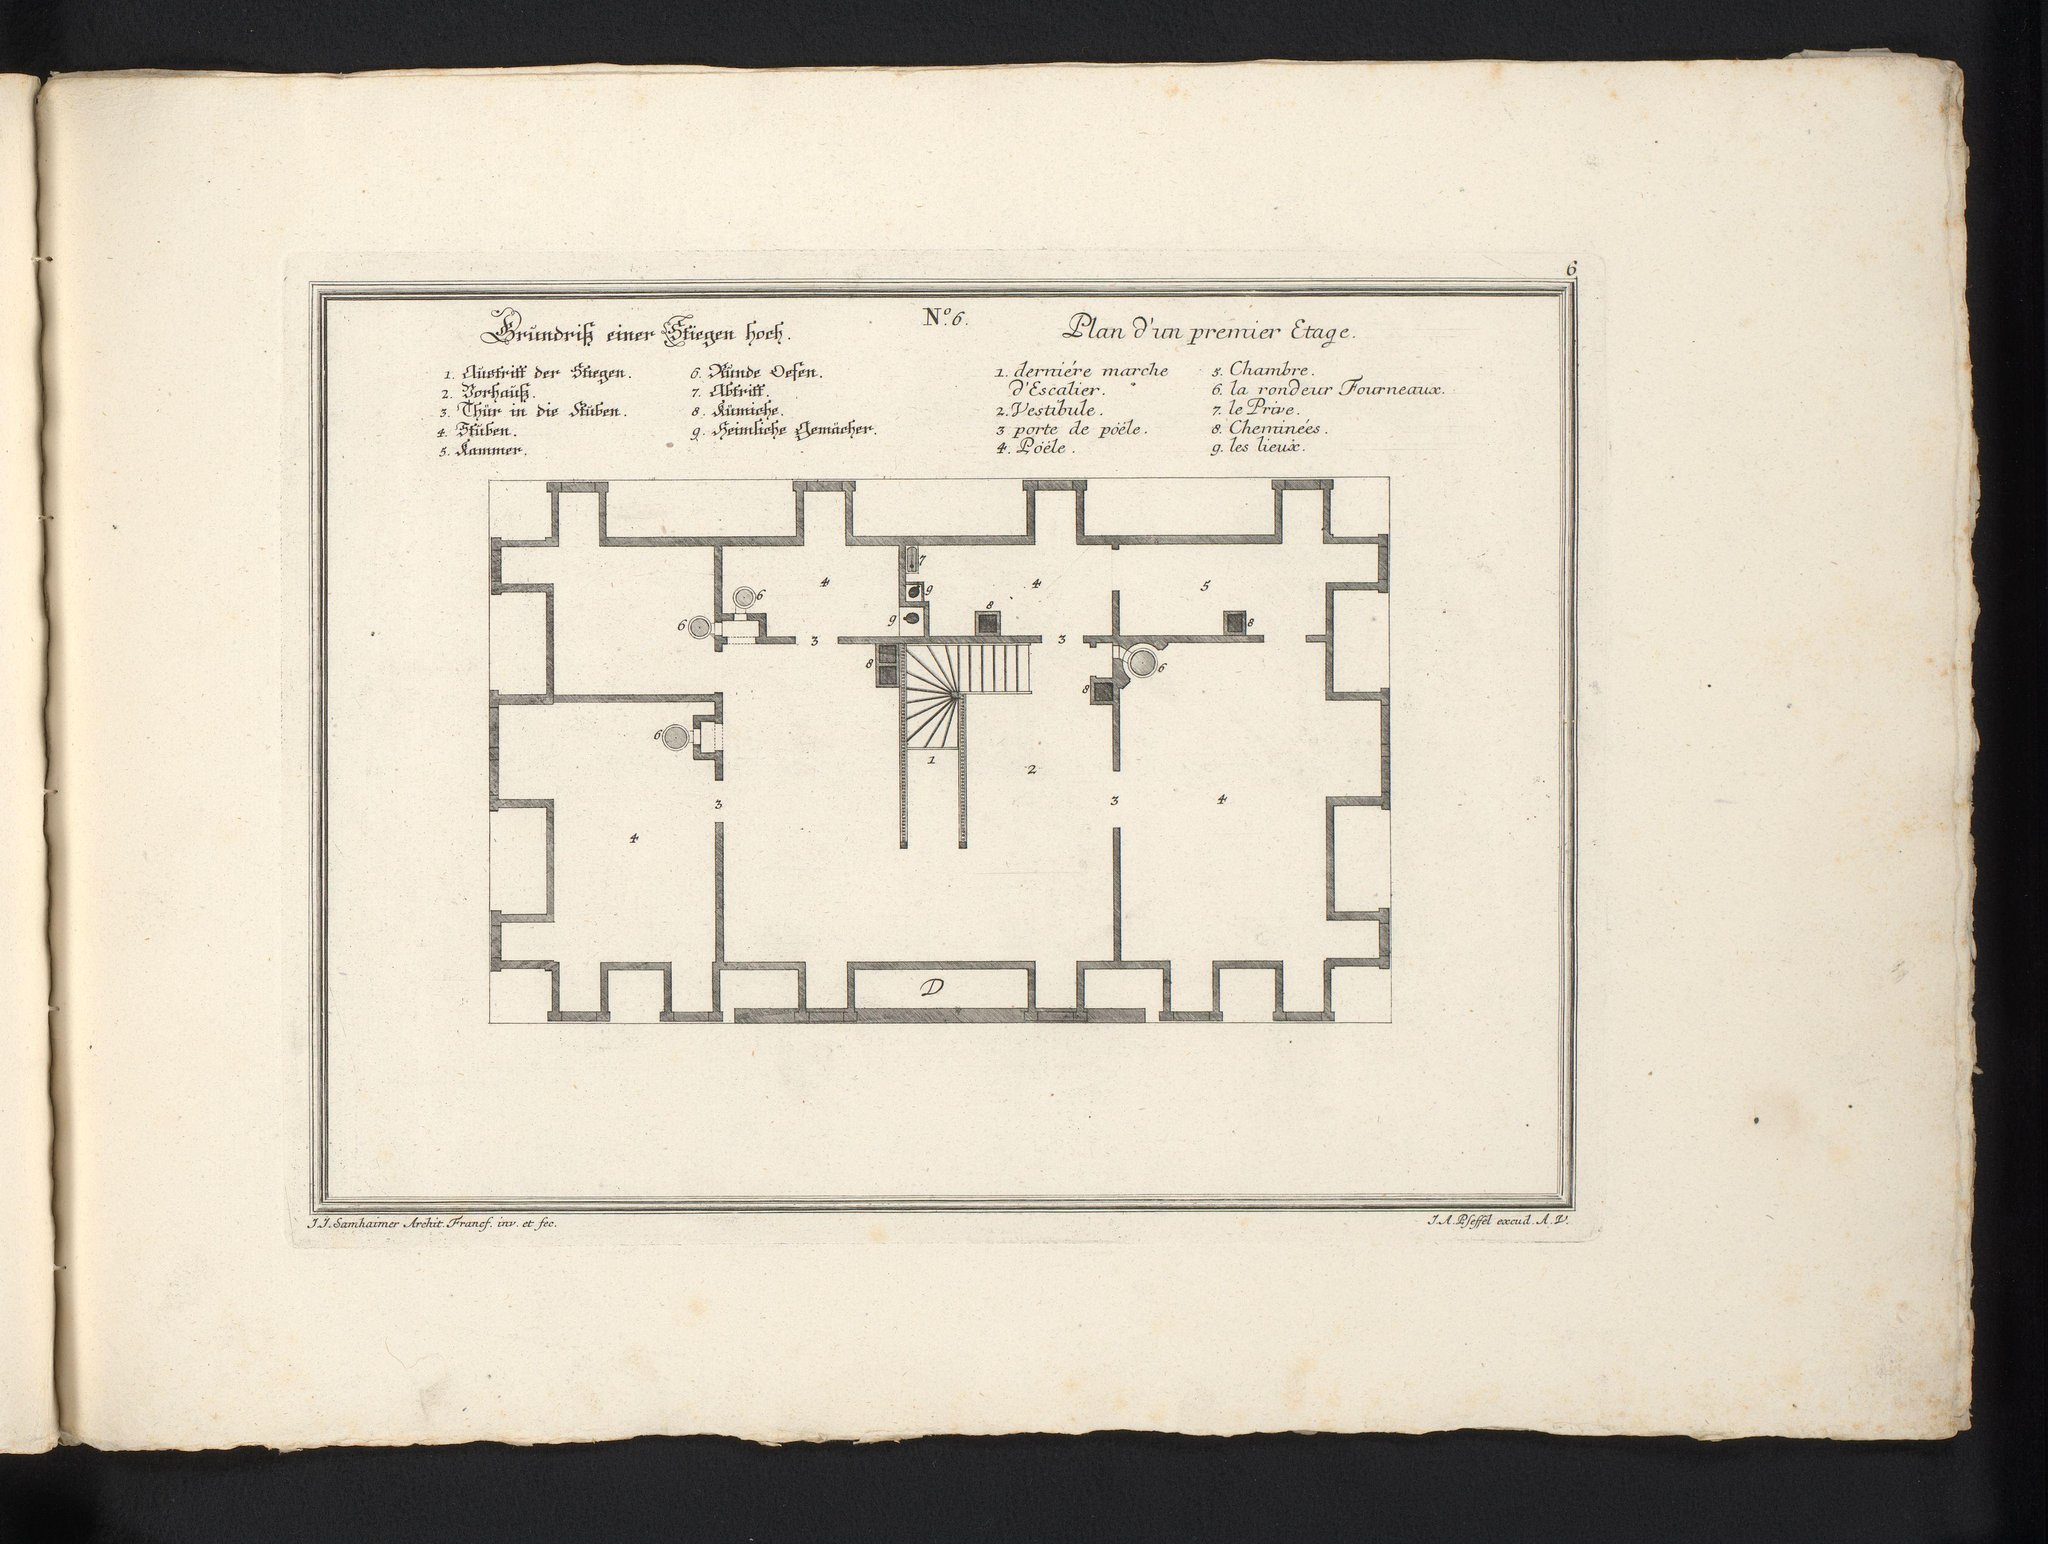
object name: print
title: Gündriss einer stiegen hoch / Plan d'un premier etage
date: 1729-1730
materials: paper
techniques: engraving, etching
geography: augsburg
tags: prison, jail, barracks, plan ~ architecture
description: Boven, in het midden, en rechtsboven genummerd: 6.